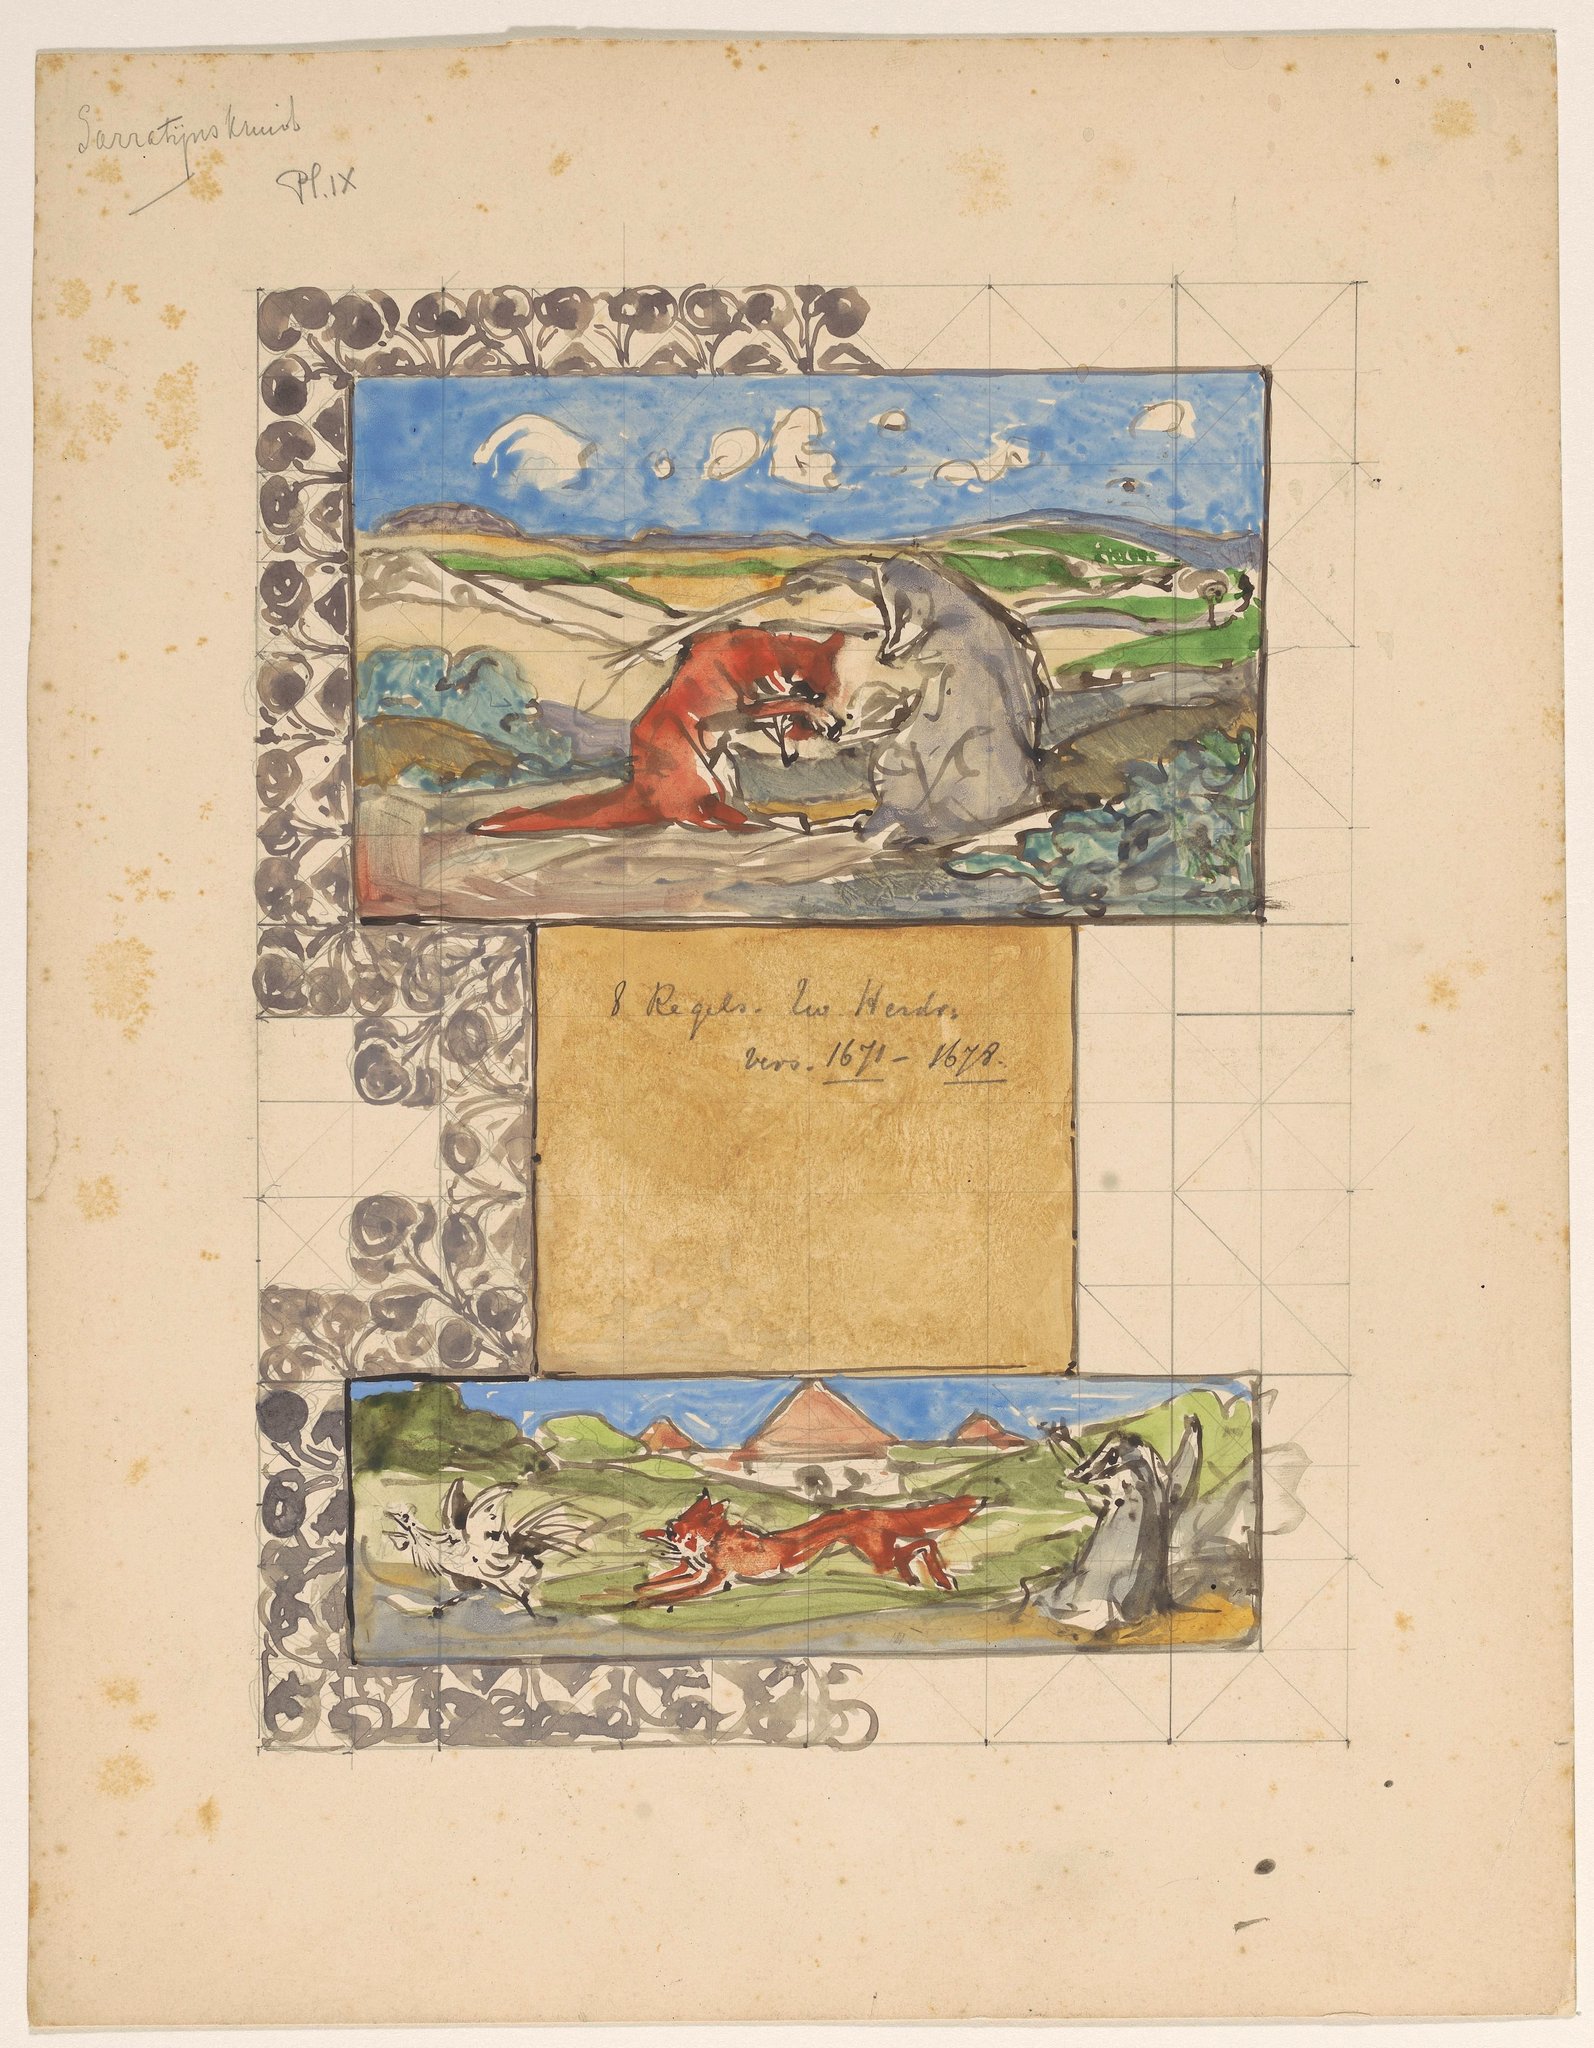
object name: design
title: Grimbert geeft Reinaert stokslagen en Reinaerts aanval op een haan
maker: bernard willem wierink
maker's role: draughtsman, print maker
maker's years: 1856-1939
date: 1866-1939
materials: cardboard, pencil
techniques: brush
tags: fable of reynard the fox